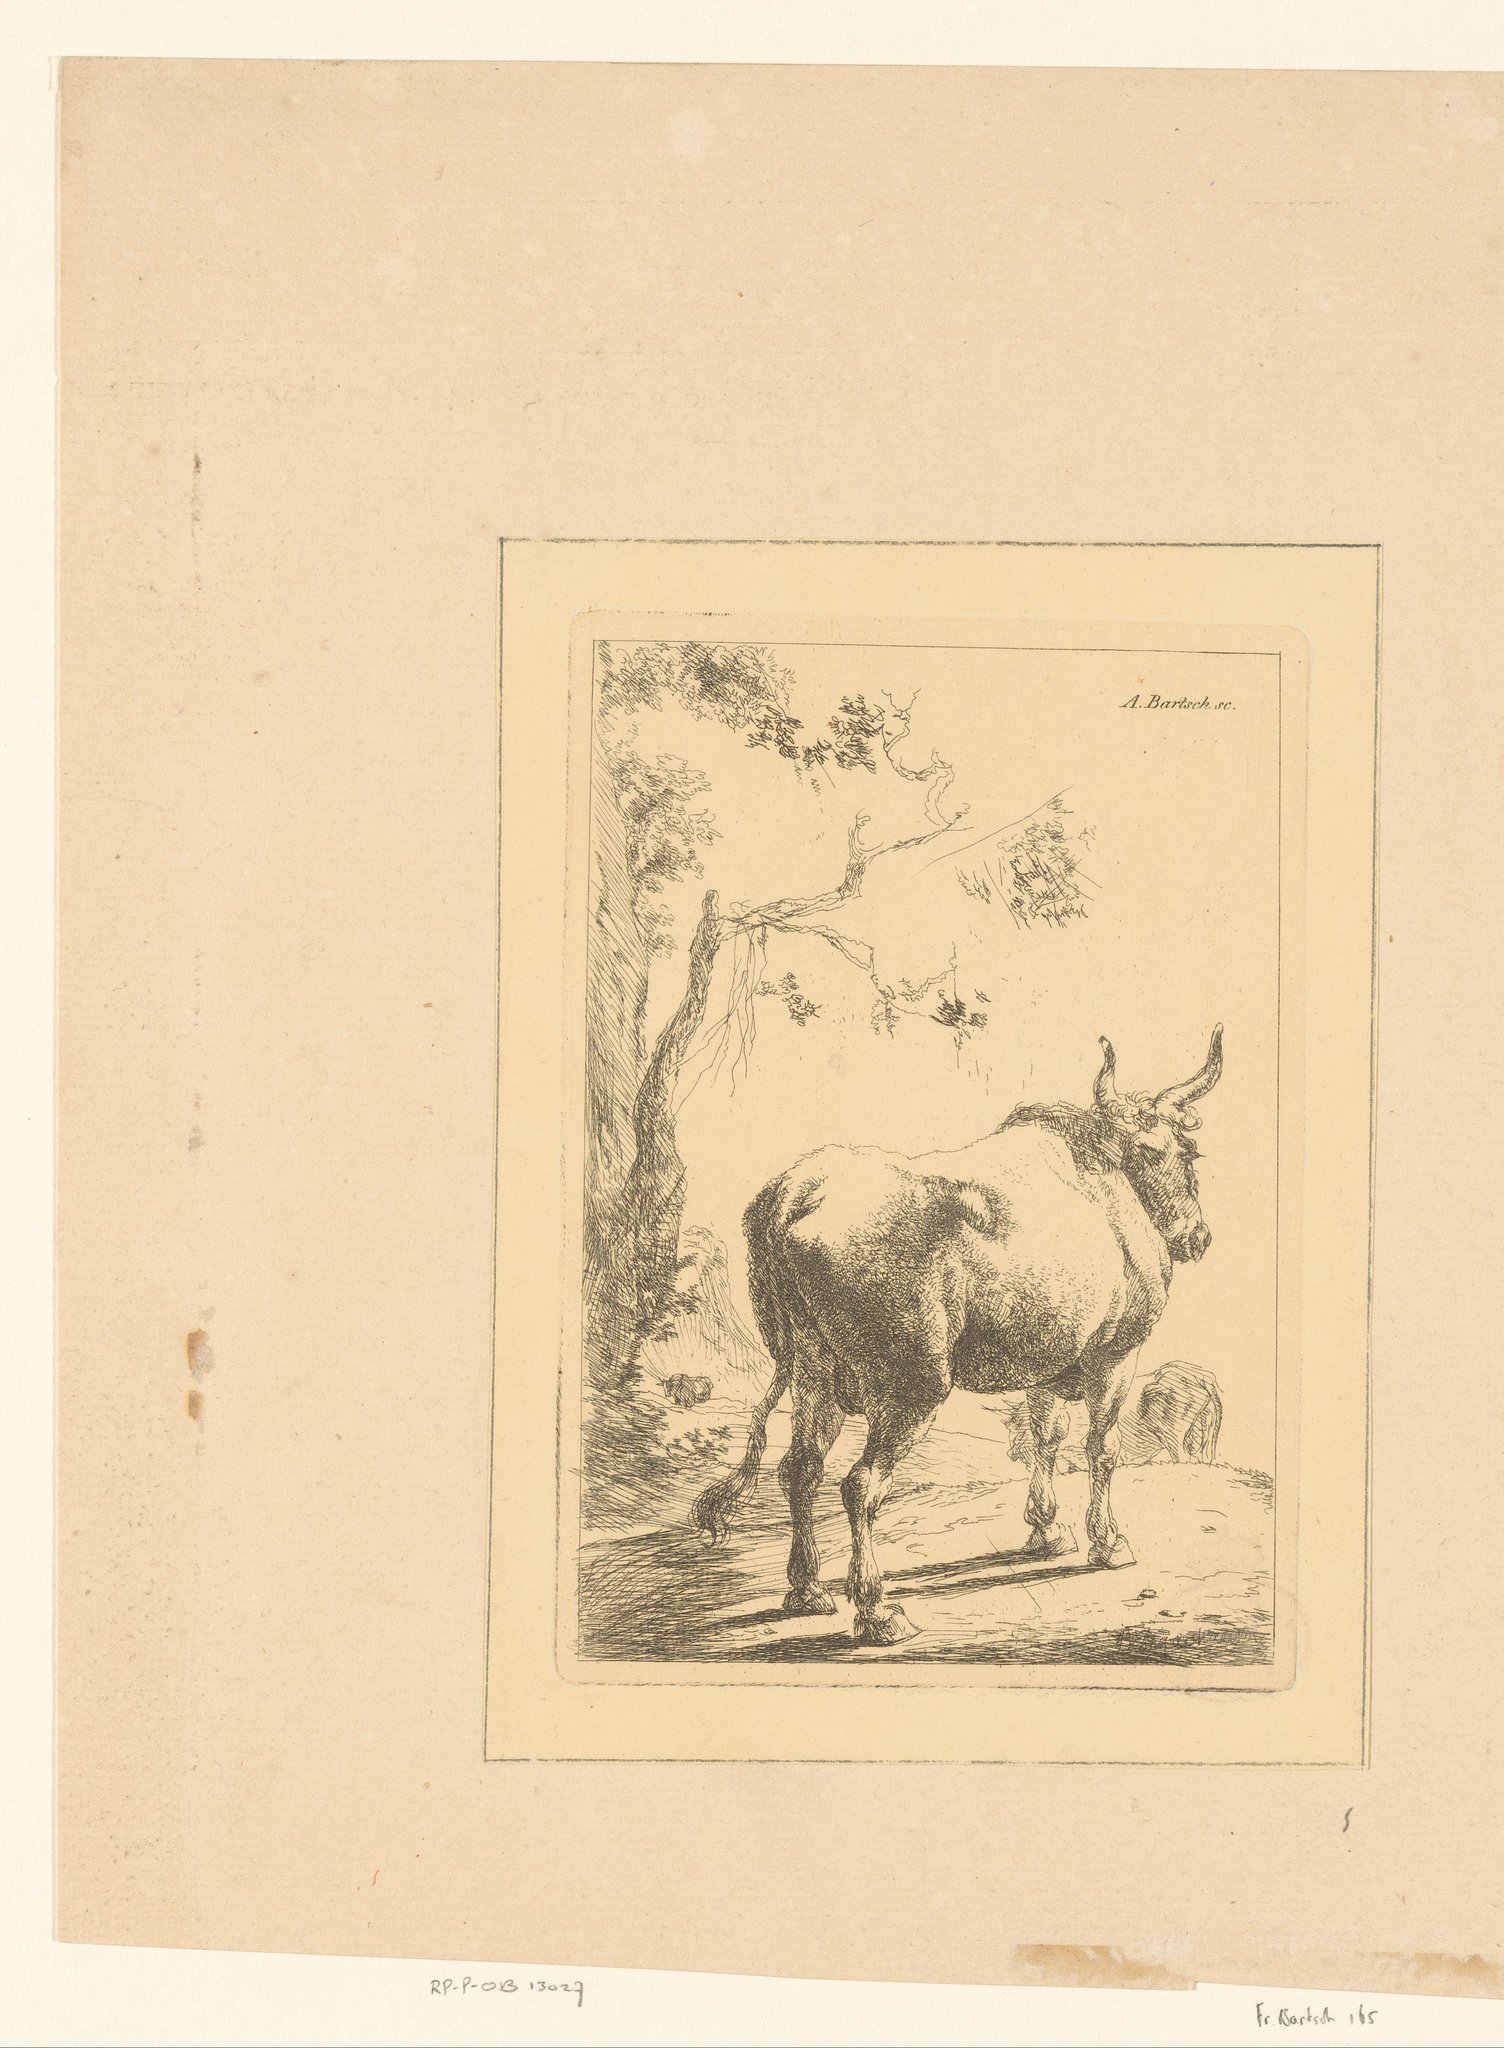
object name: print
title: Stier van achteren gezien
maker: adam von bartsch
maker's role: print maker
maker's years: 1757-1821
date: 1803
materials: paper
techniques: etching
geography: vienna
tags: bull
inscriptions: collector's mark: Lugt 12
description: Mogelijk afkomstig uit het album: Copies faites d'après des estampes très rares (...) décrites dans les volumes I. IV. et V. du peintre graveur, par Adam Bartsch (RP-P-OB-13.069).